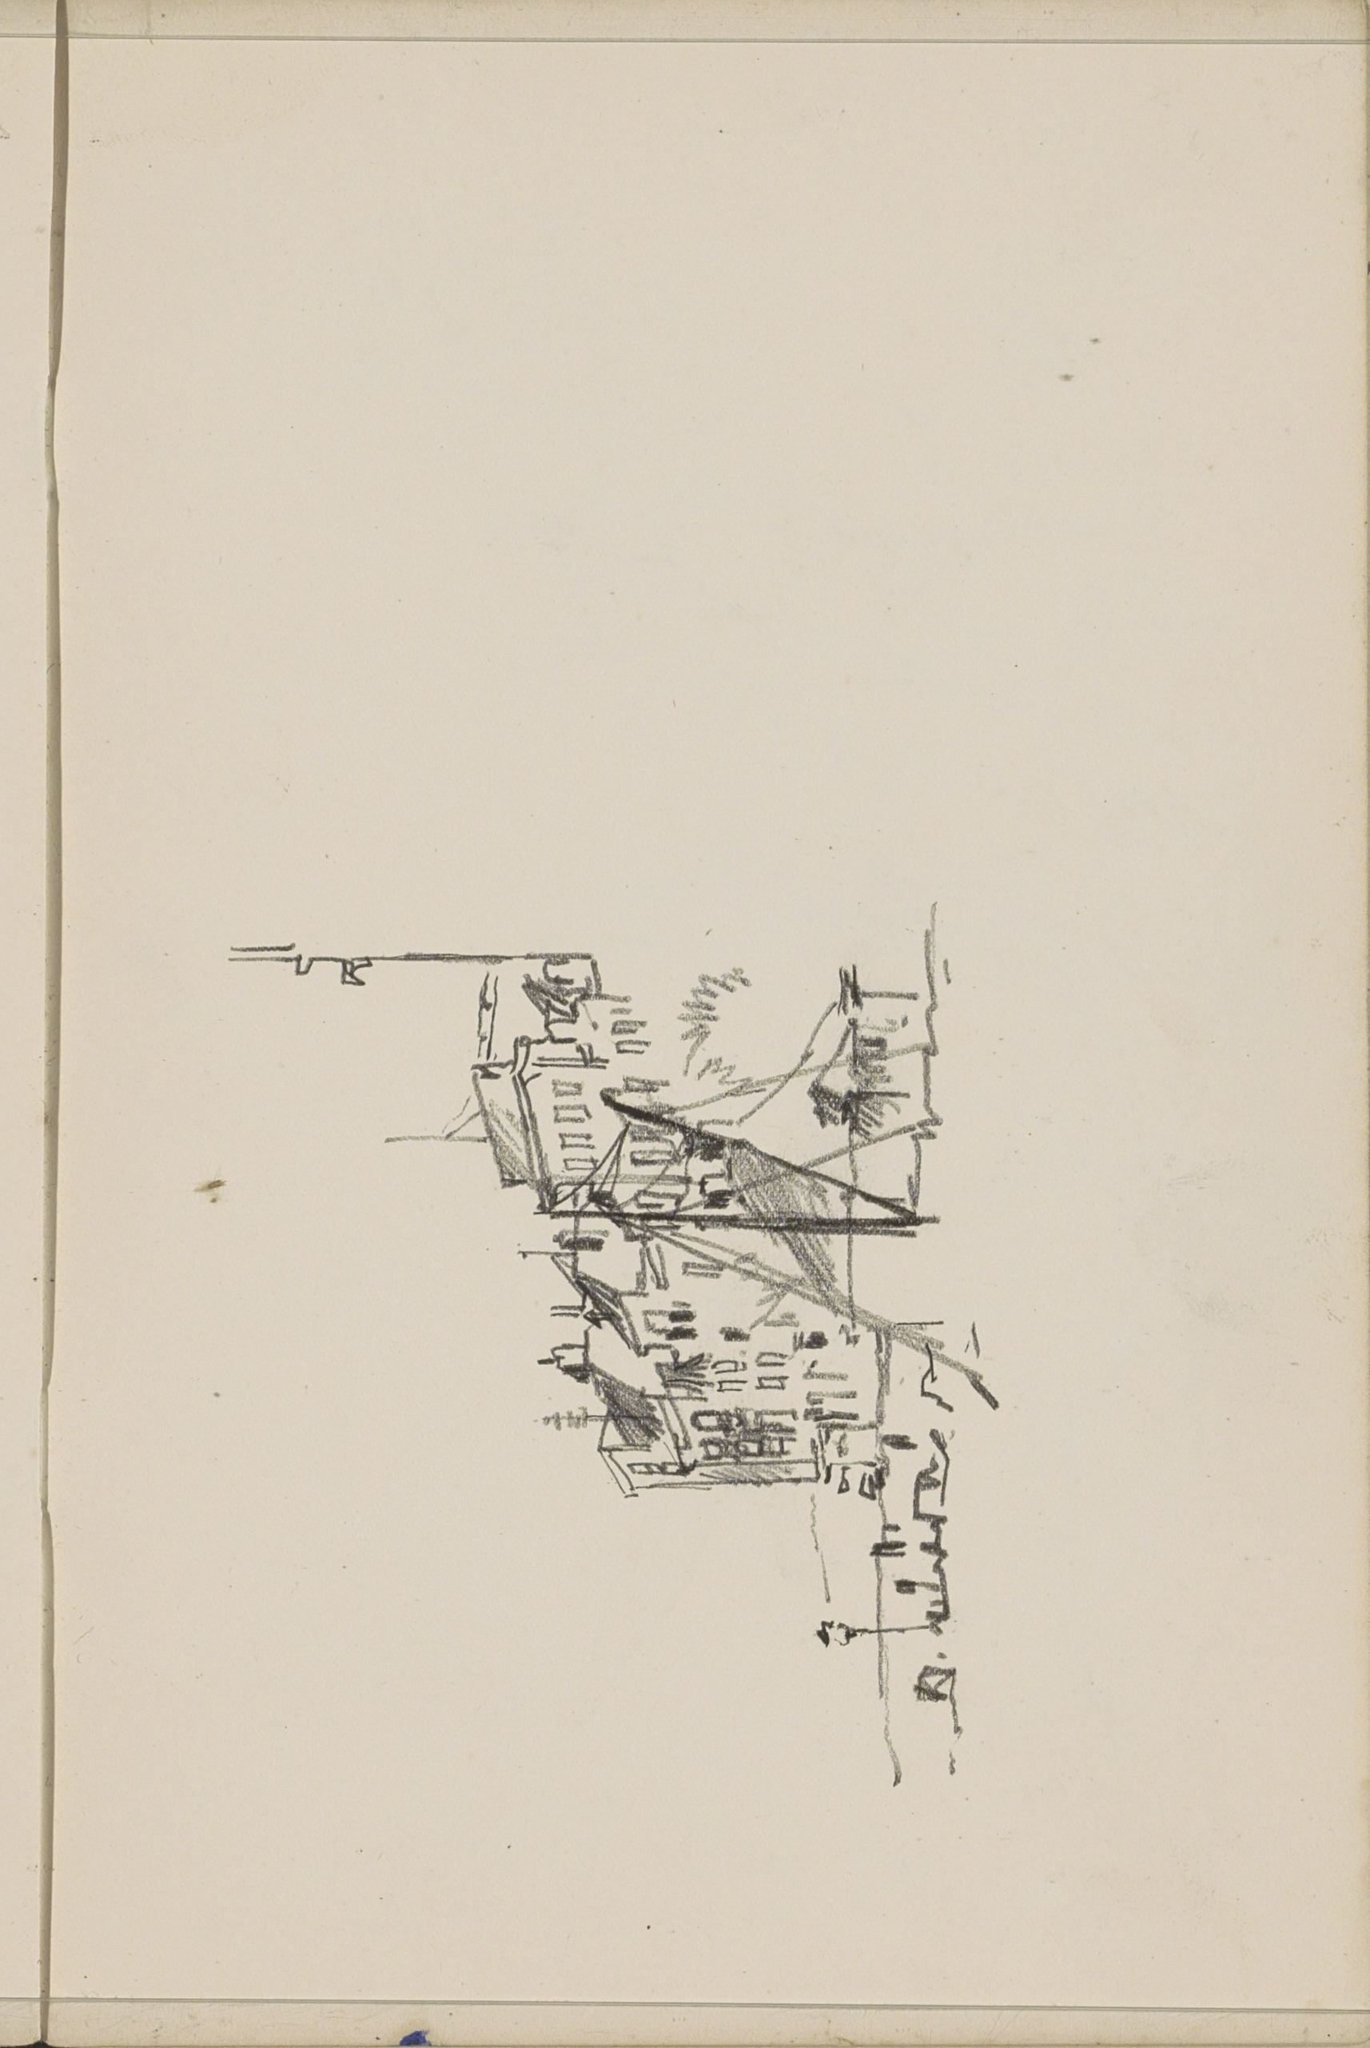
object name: sketchbook leaf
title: Rij huizen aan een kade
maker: cornelis vreedenburgh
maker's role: draughtsman, print maker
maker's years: 1880-1946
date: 1890-1946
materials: chalk, paper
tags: the usual house or row of houses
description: Blad 17 recto uit een schetsboek met 47 bladen.